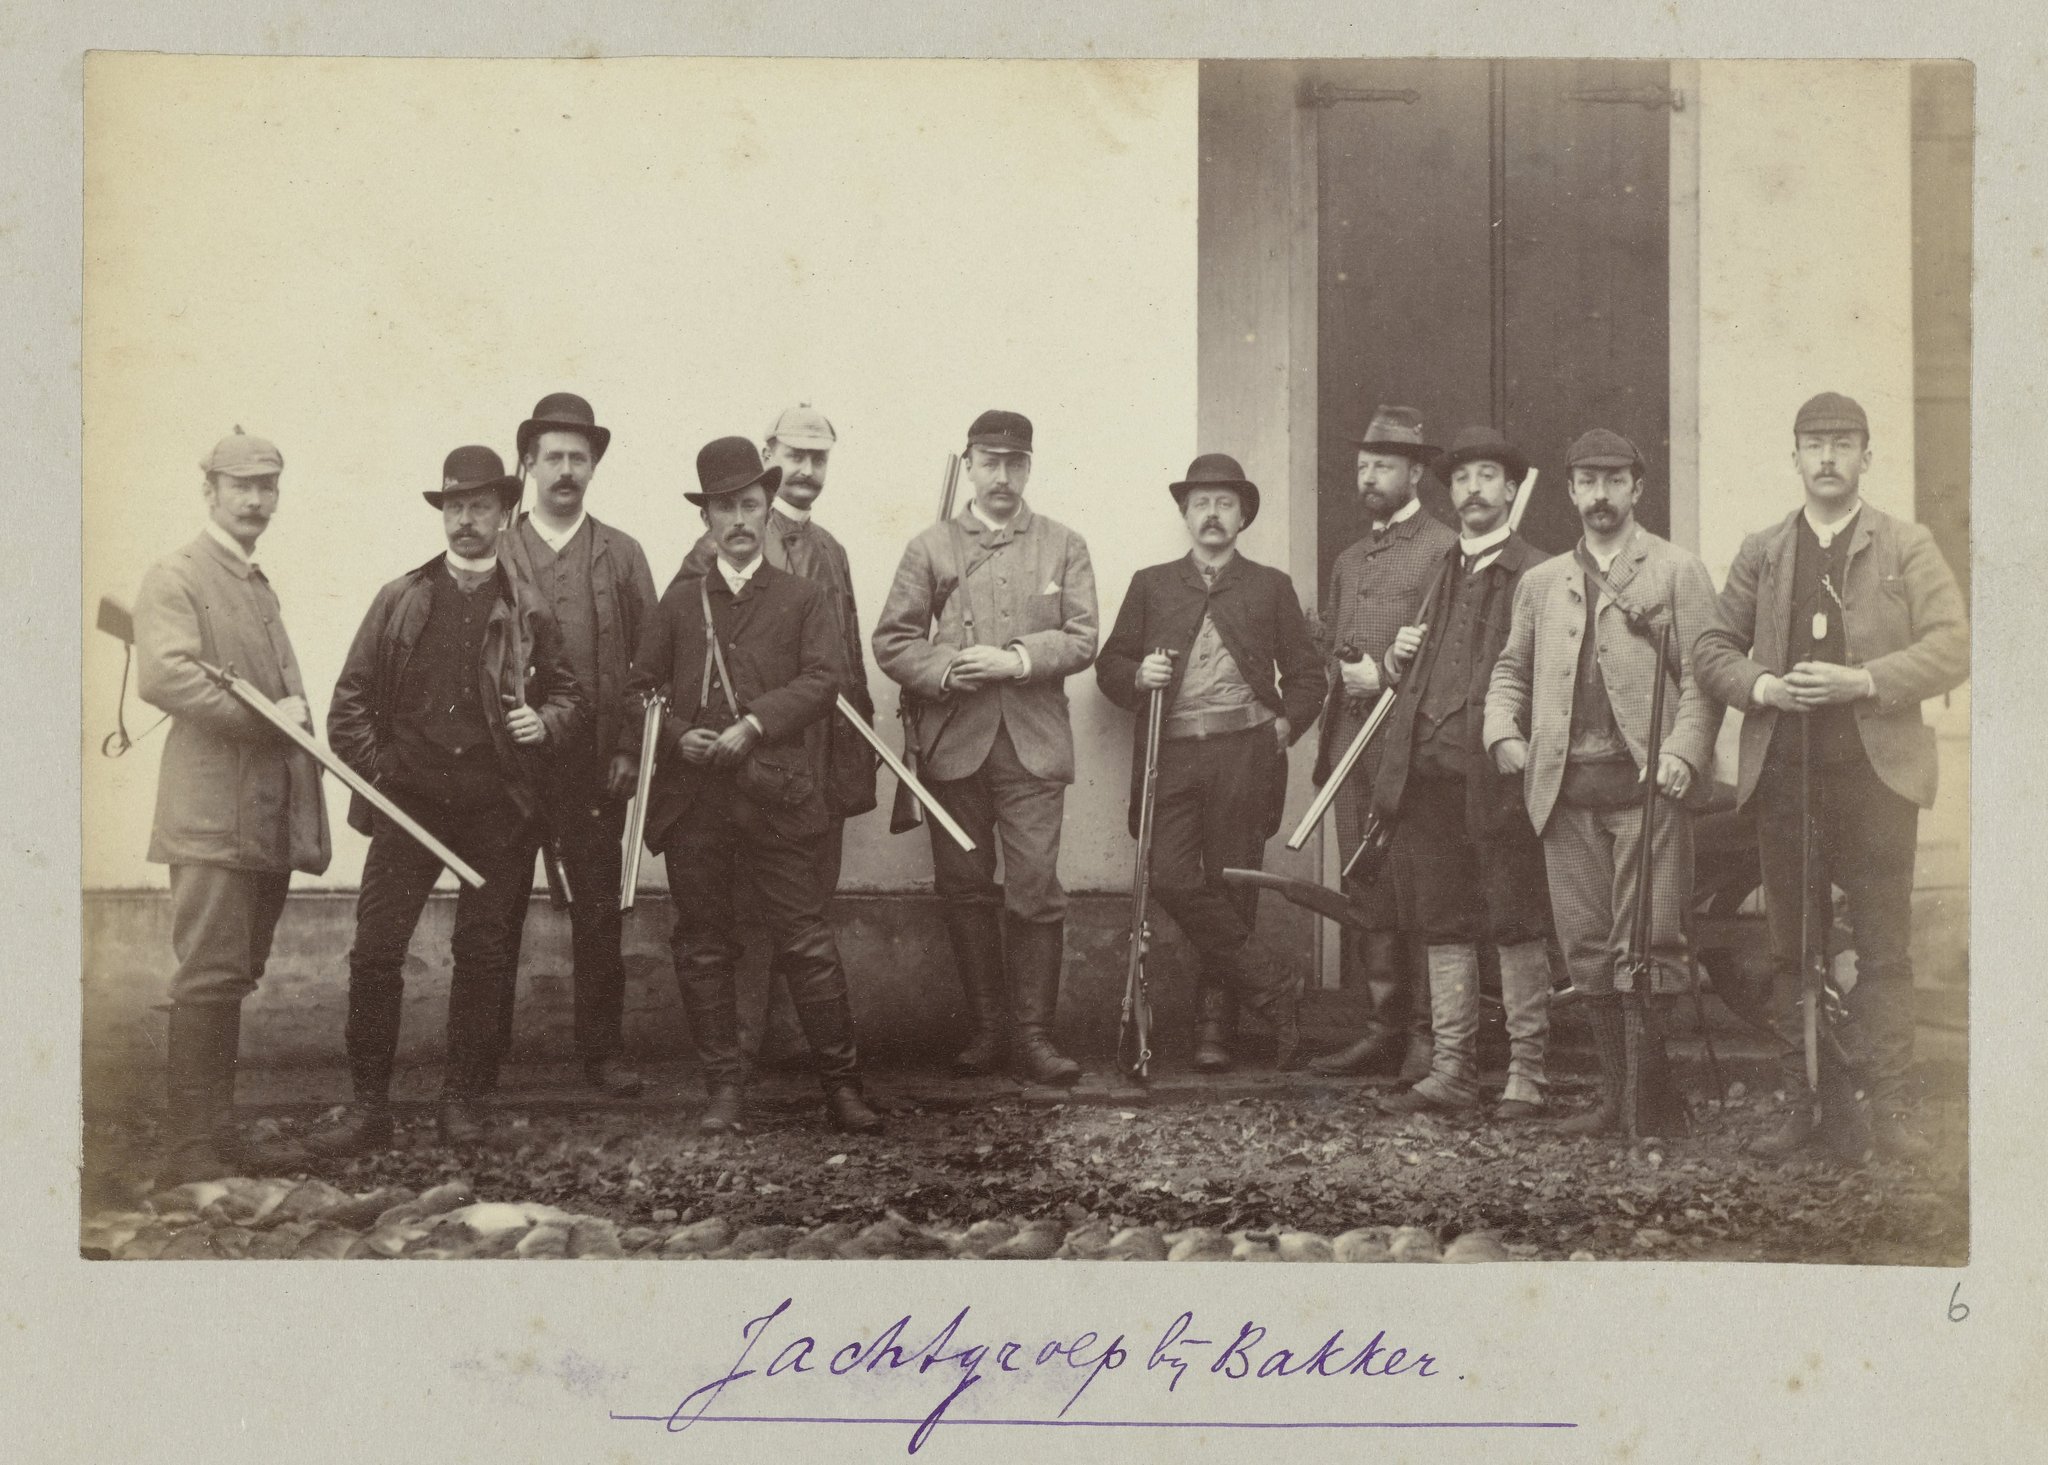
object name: photograph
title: Hunting Scene | Group Portrait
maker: henry pauw van wieldrecht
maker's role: fotograaf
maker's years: 1863-1912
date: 1888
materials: paper, photographic support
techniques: albumen print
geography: netherlands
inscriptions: title: ‘Jachtgroep bij Bakker’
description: This is a selfie from 1888. The photographer (right) lies on the ground and holds a cable release. He and his family members are clearly enjoying themselves. They look relaxed and not as stiff and posed as was usual in portraits around this time. An important aspect of amateur photography is that it enabled engaging so closely with personal life.